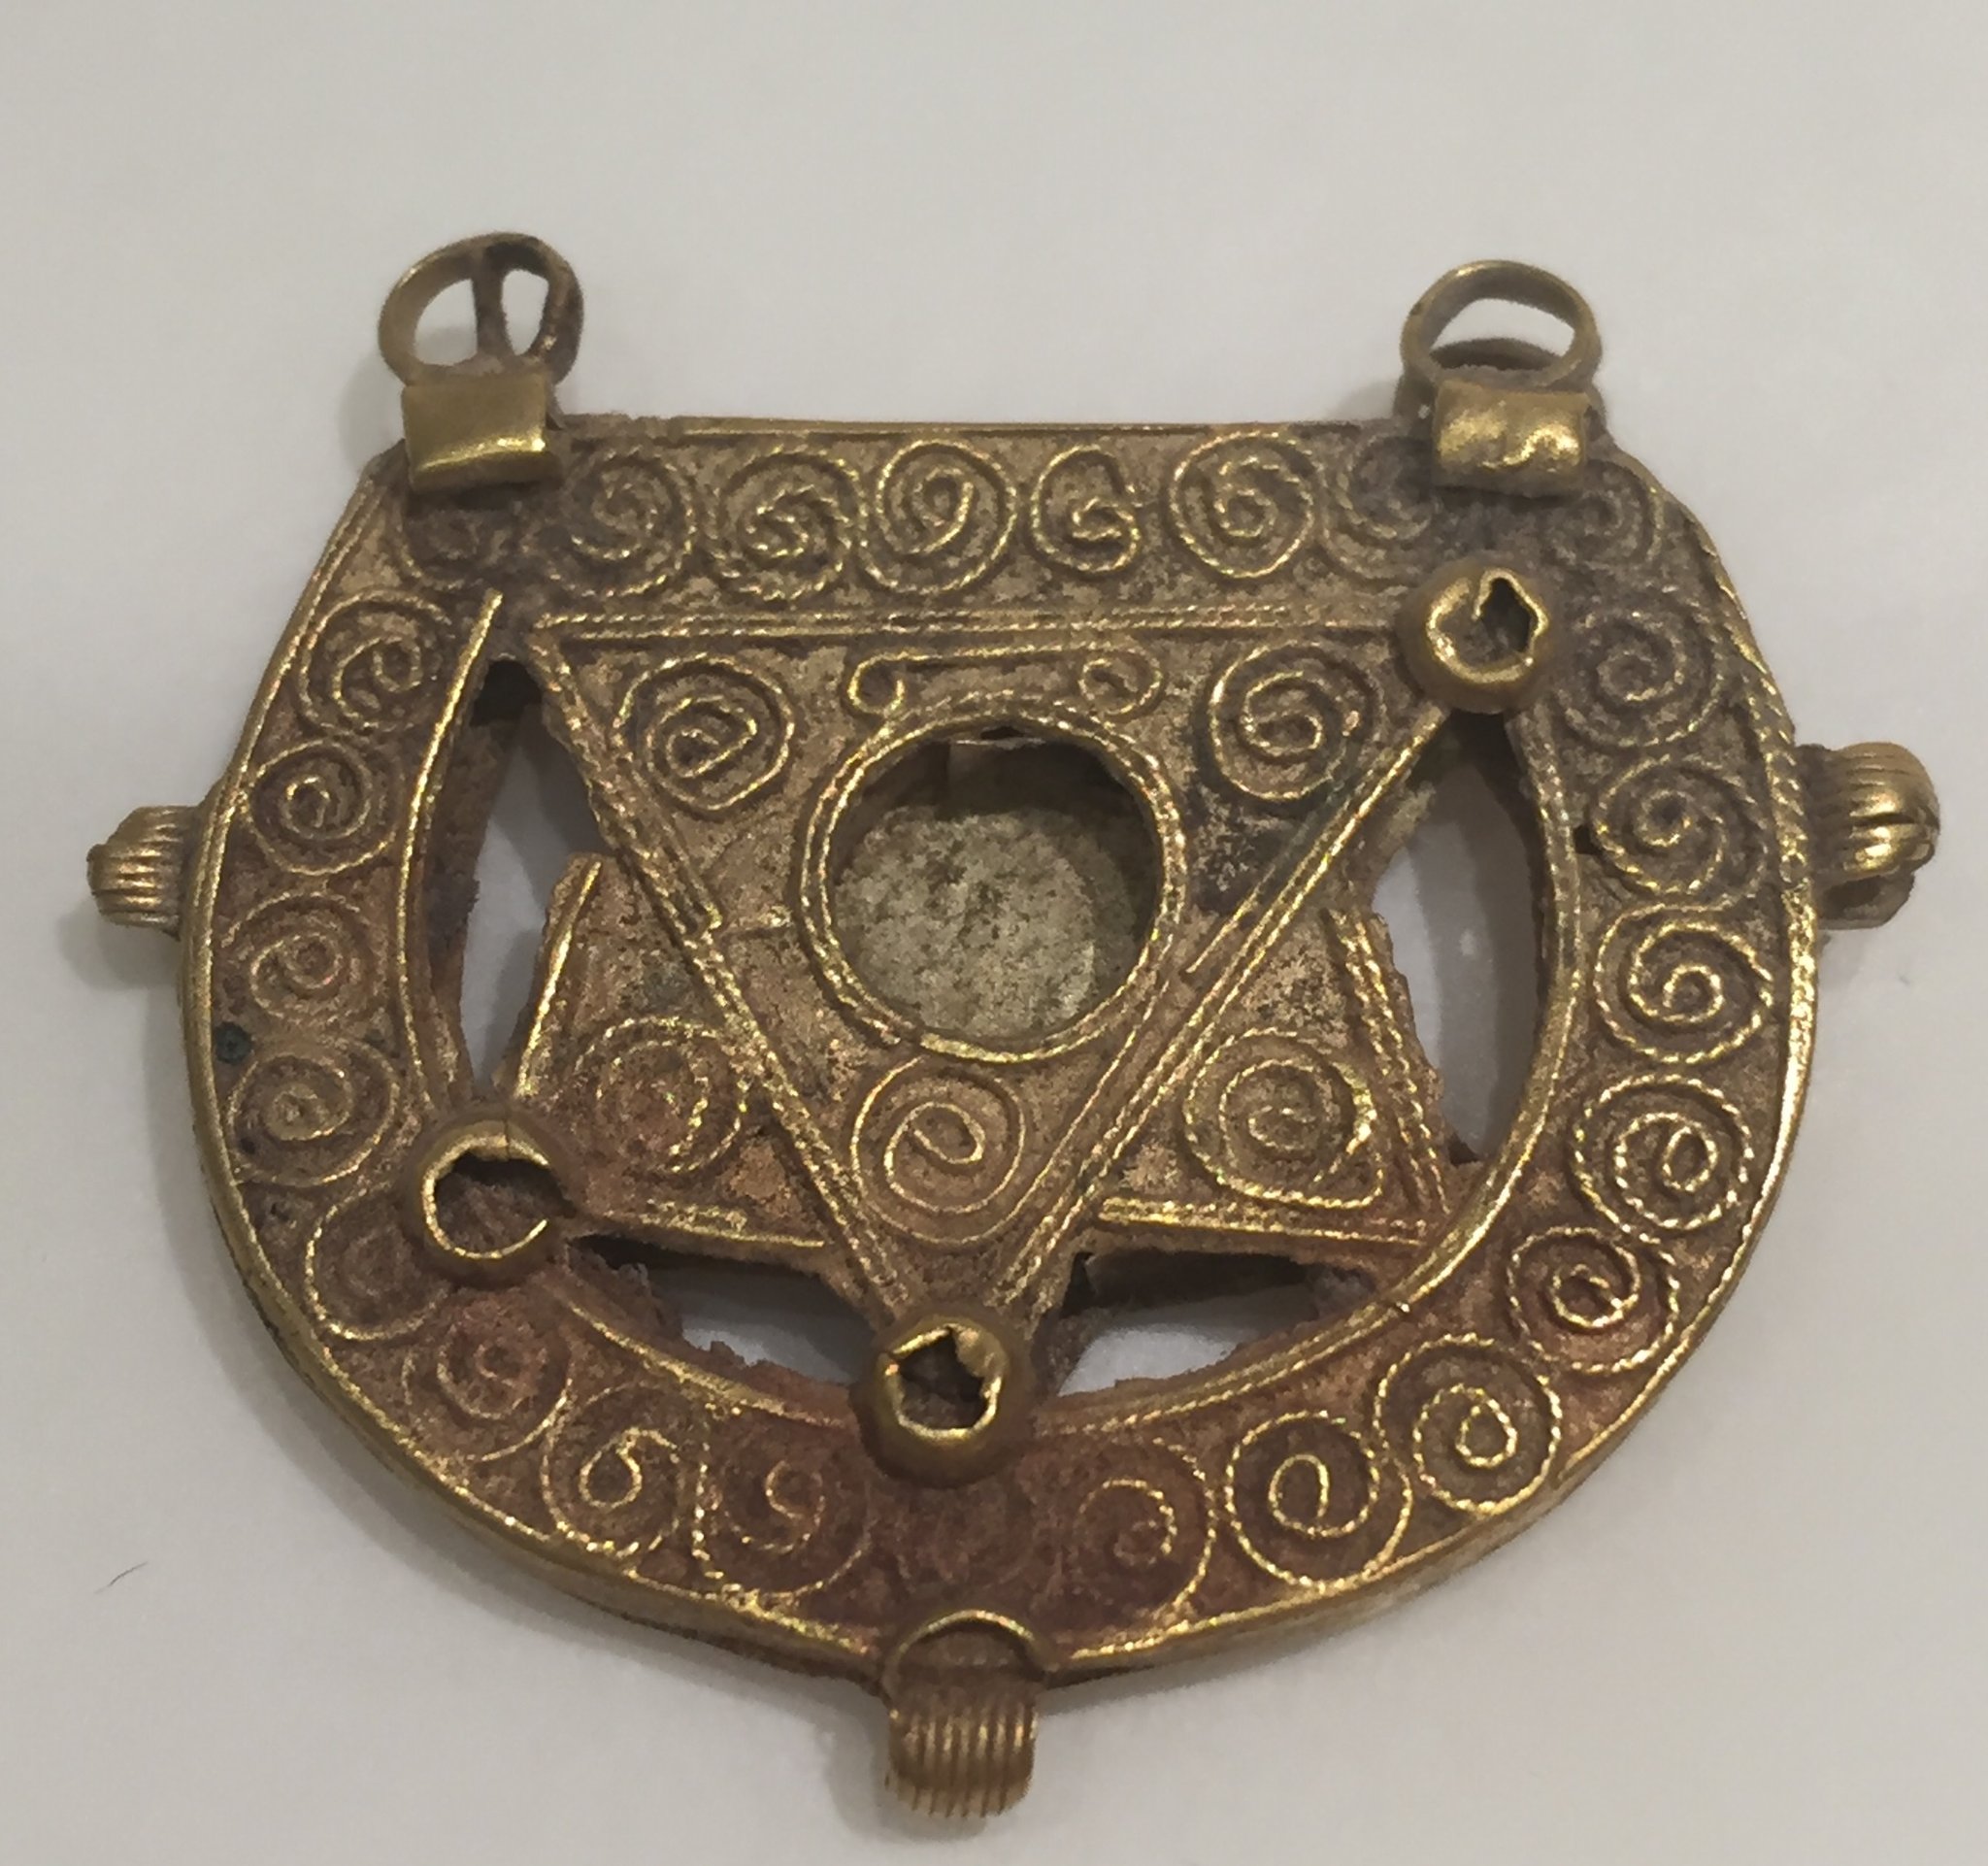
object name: earring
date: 1001-1300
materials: gold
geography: iraq